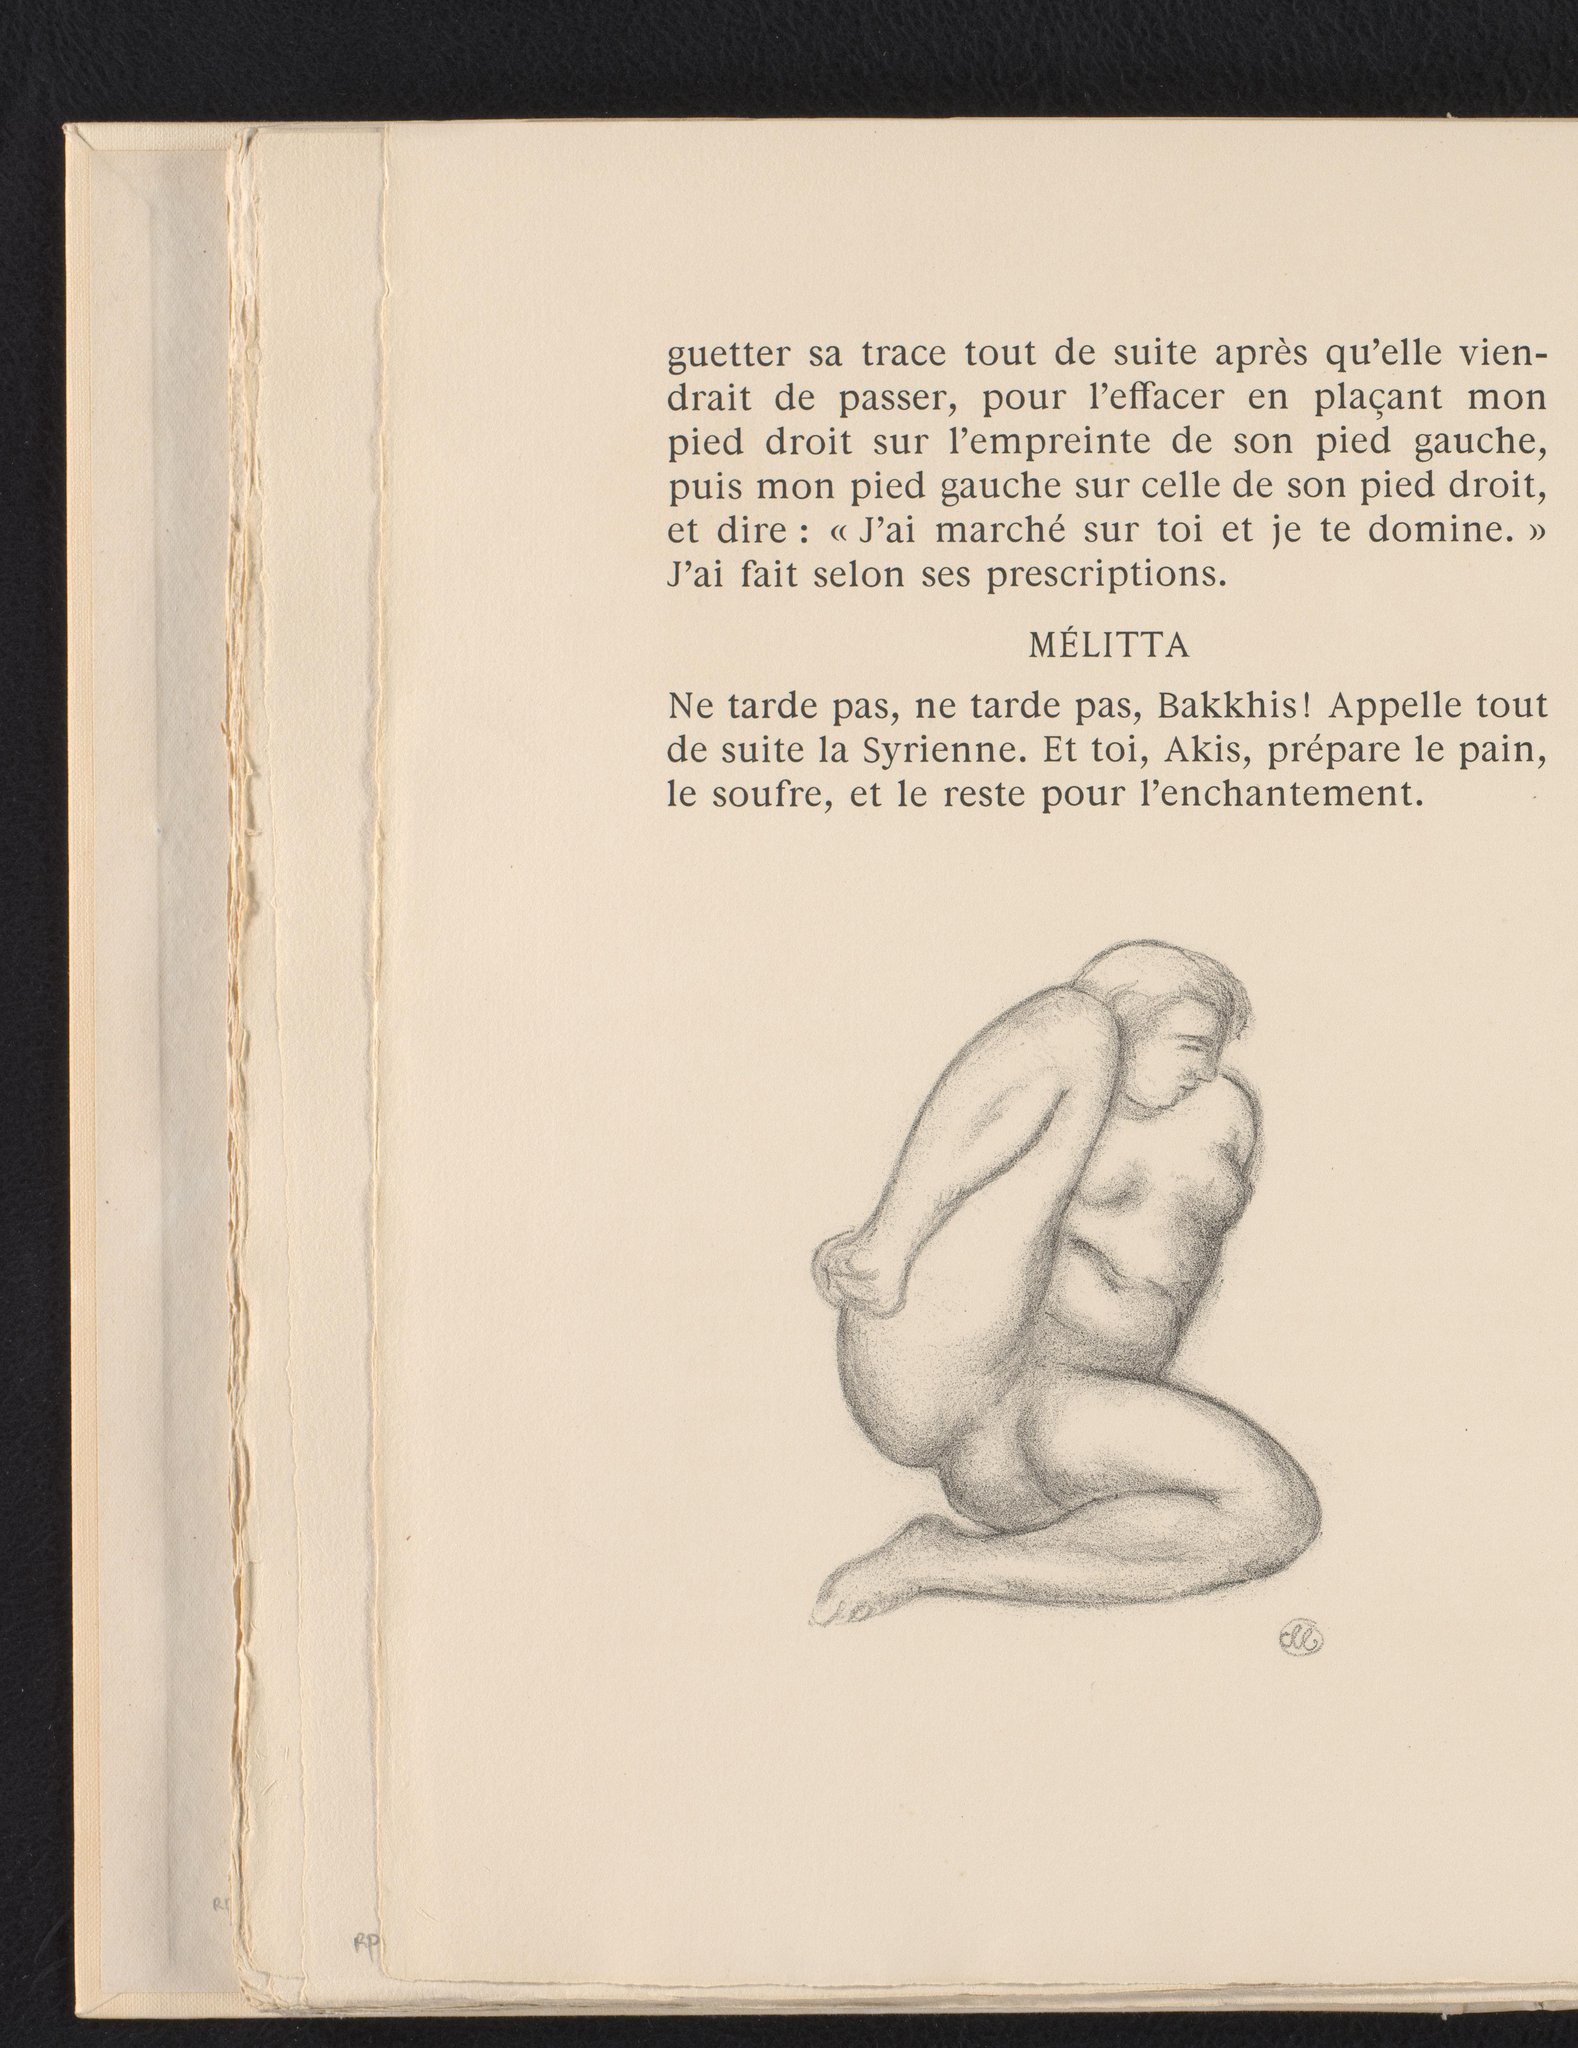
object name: print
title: Liggende naakte vrouw met gespreide benen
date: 1948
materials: paper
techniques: letterpress printing, lithograph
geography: paris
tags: woman (showing herself) undressed, quasi-nude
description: Prent uit: Lucianus van Samosata. Dialogues des Courtisanes. [Vertaald uit het Grieks door] Charles Astruc. Parijs: s.n., 1948, p. 24.